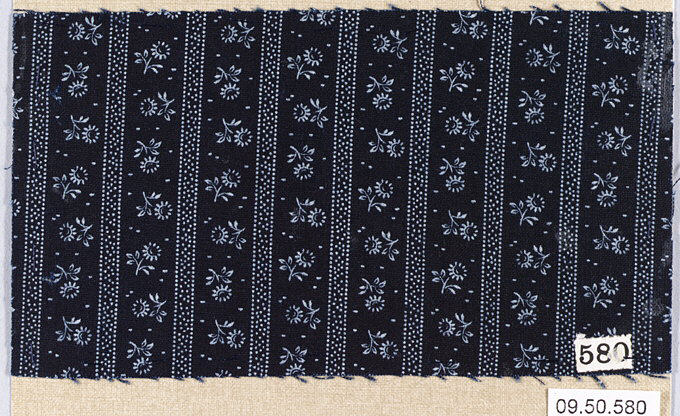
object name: piece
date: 1801-1900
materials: cotton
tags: flowers,leaves